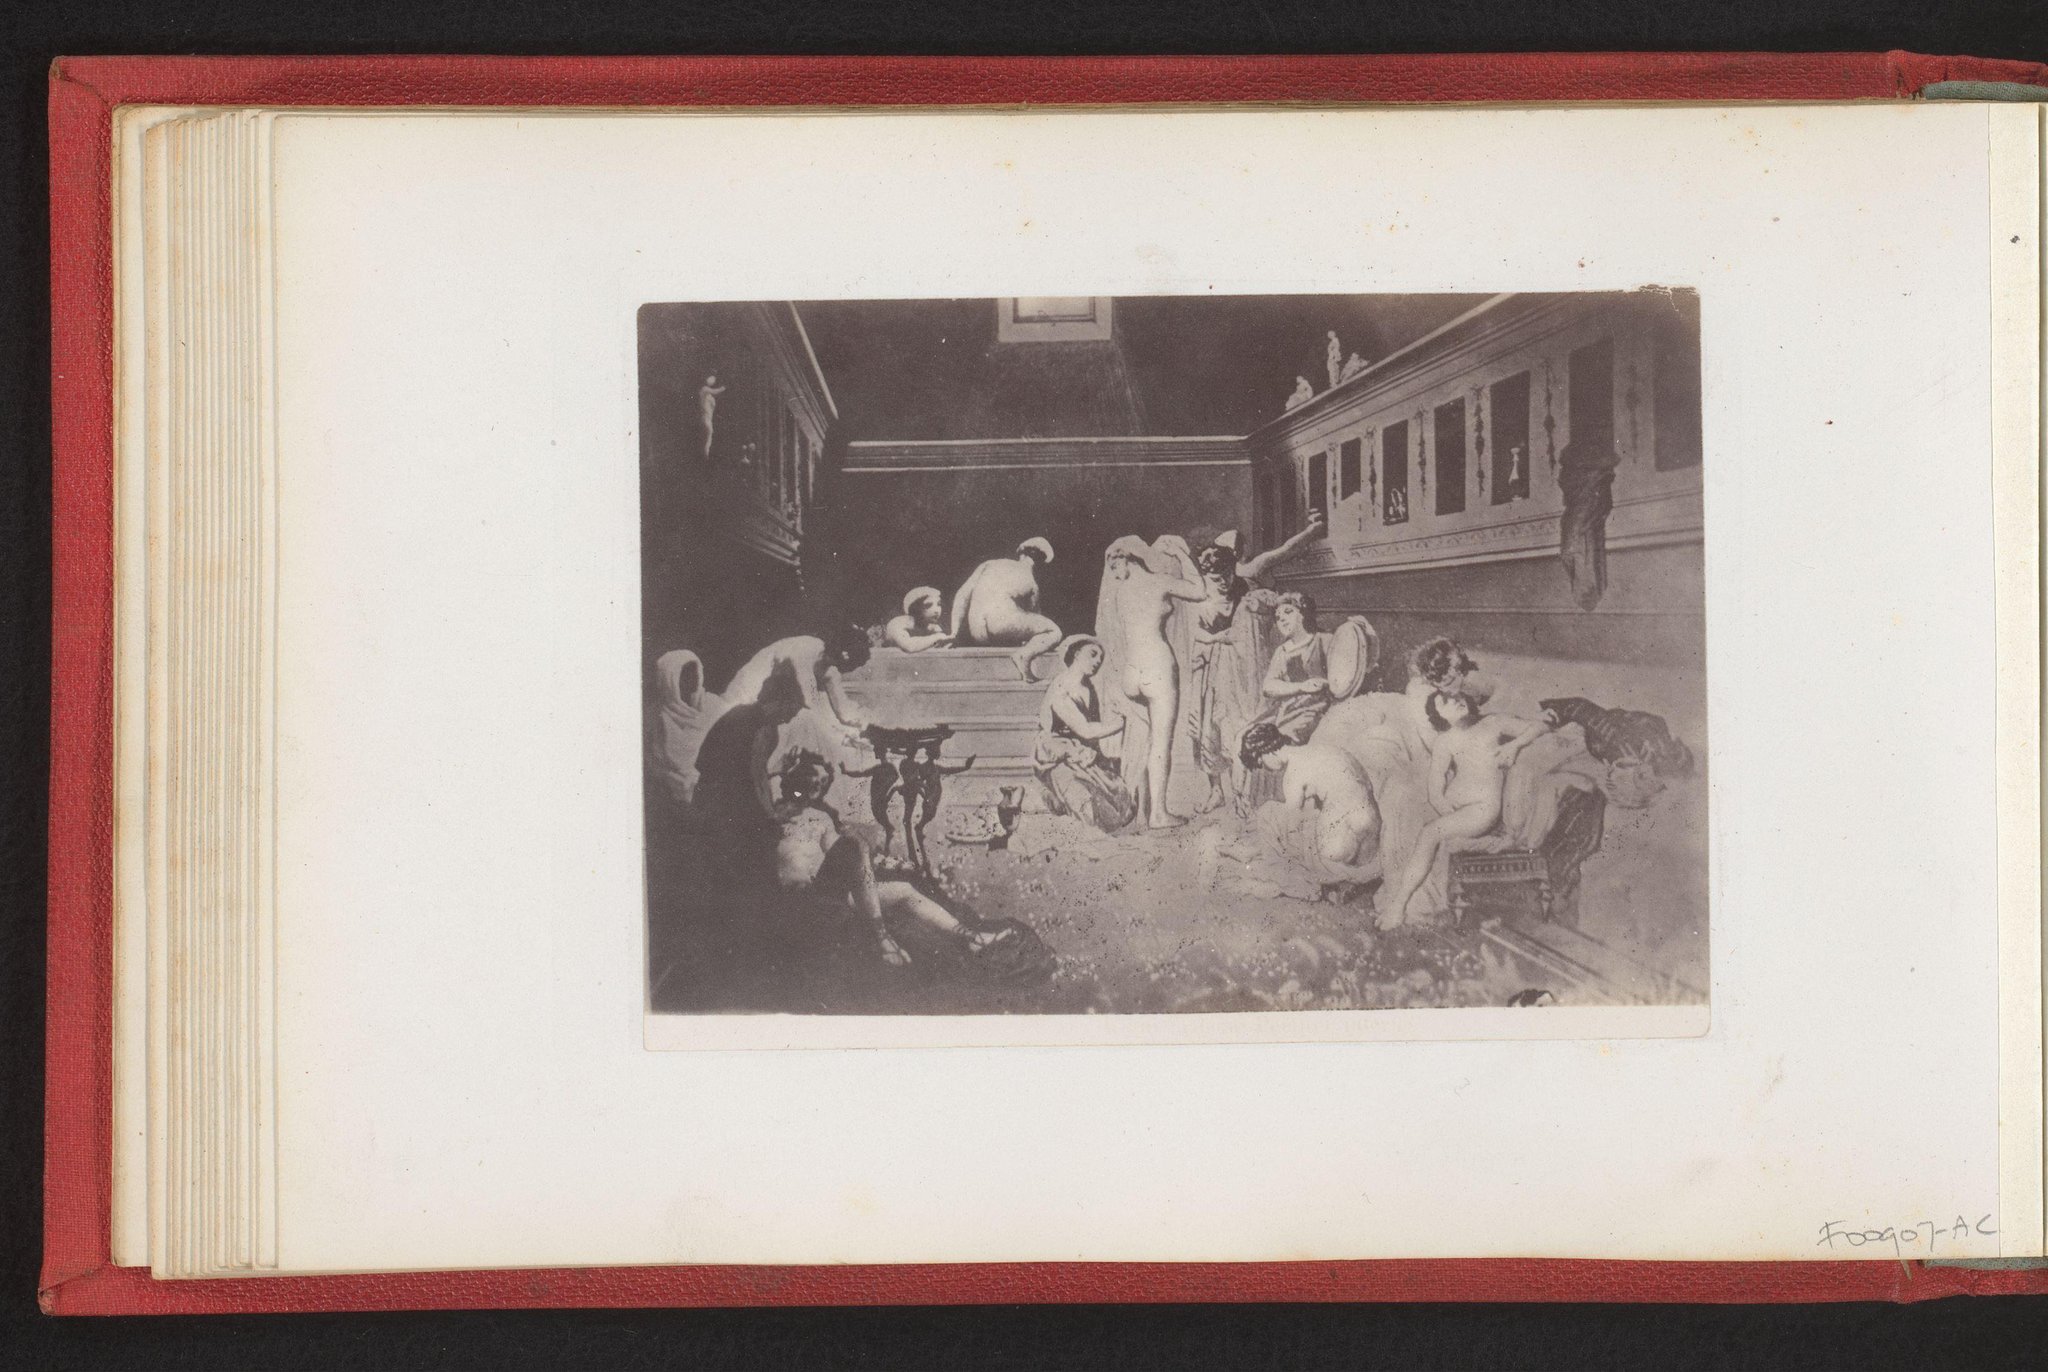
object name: photograph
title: Fotoreproductie van een prent van het interieur van een badhuis met badende vrouwen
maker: Anonymous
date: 1860-1900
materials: photographic support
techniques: albumen print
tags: the graphic arts, public baths